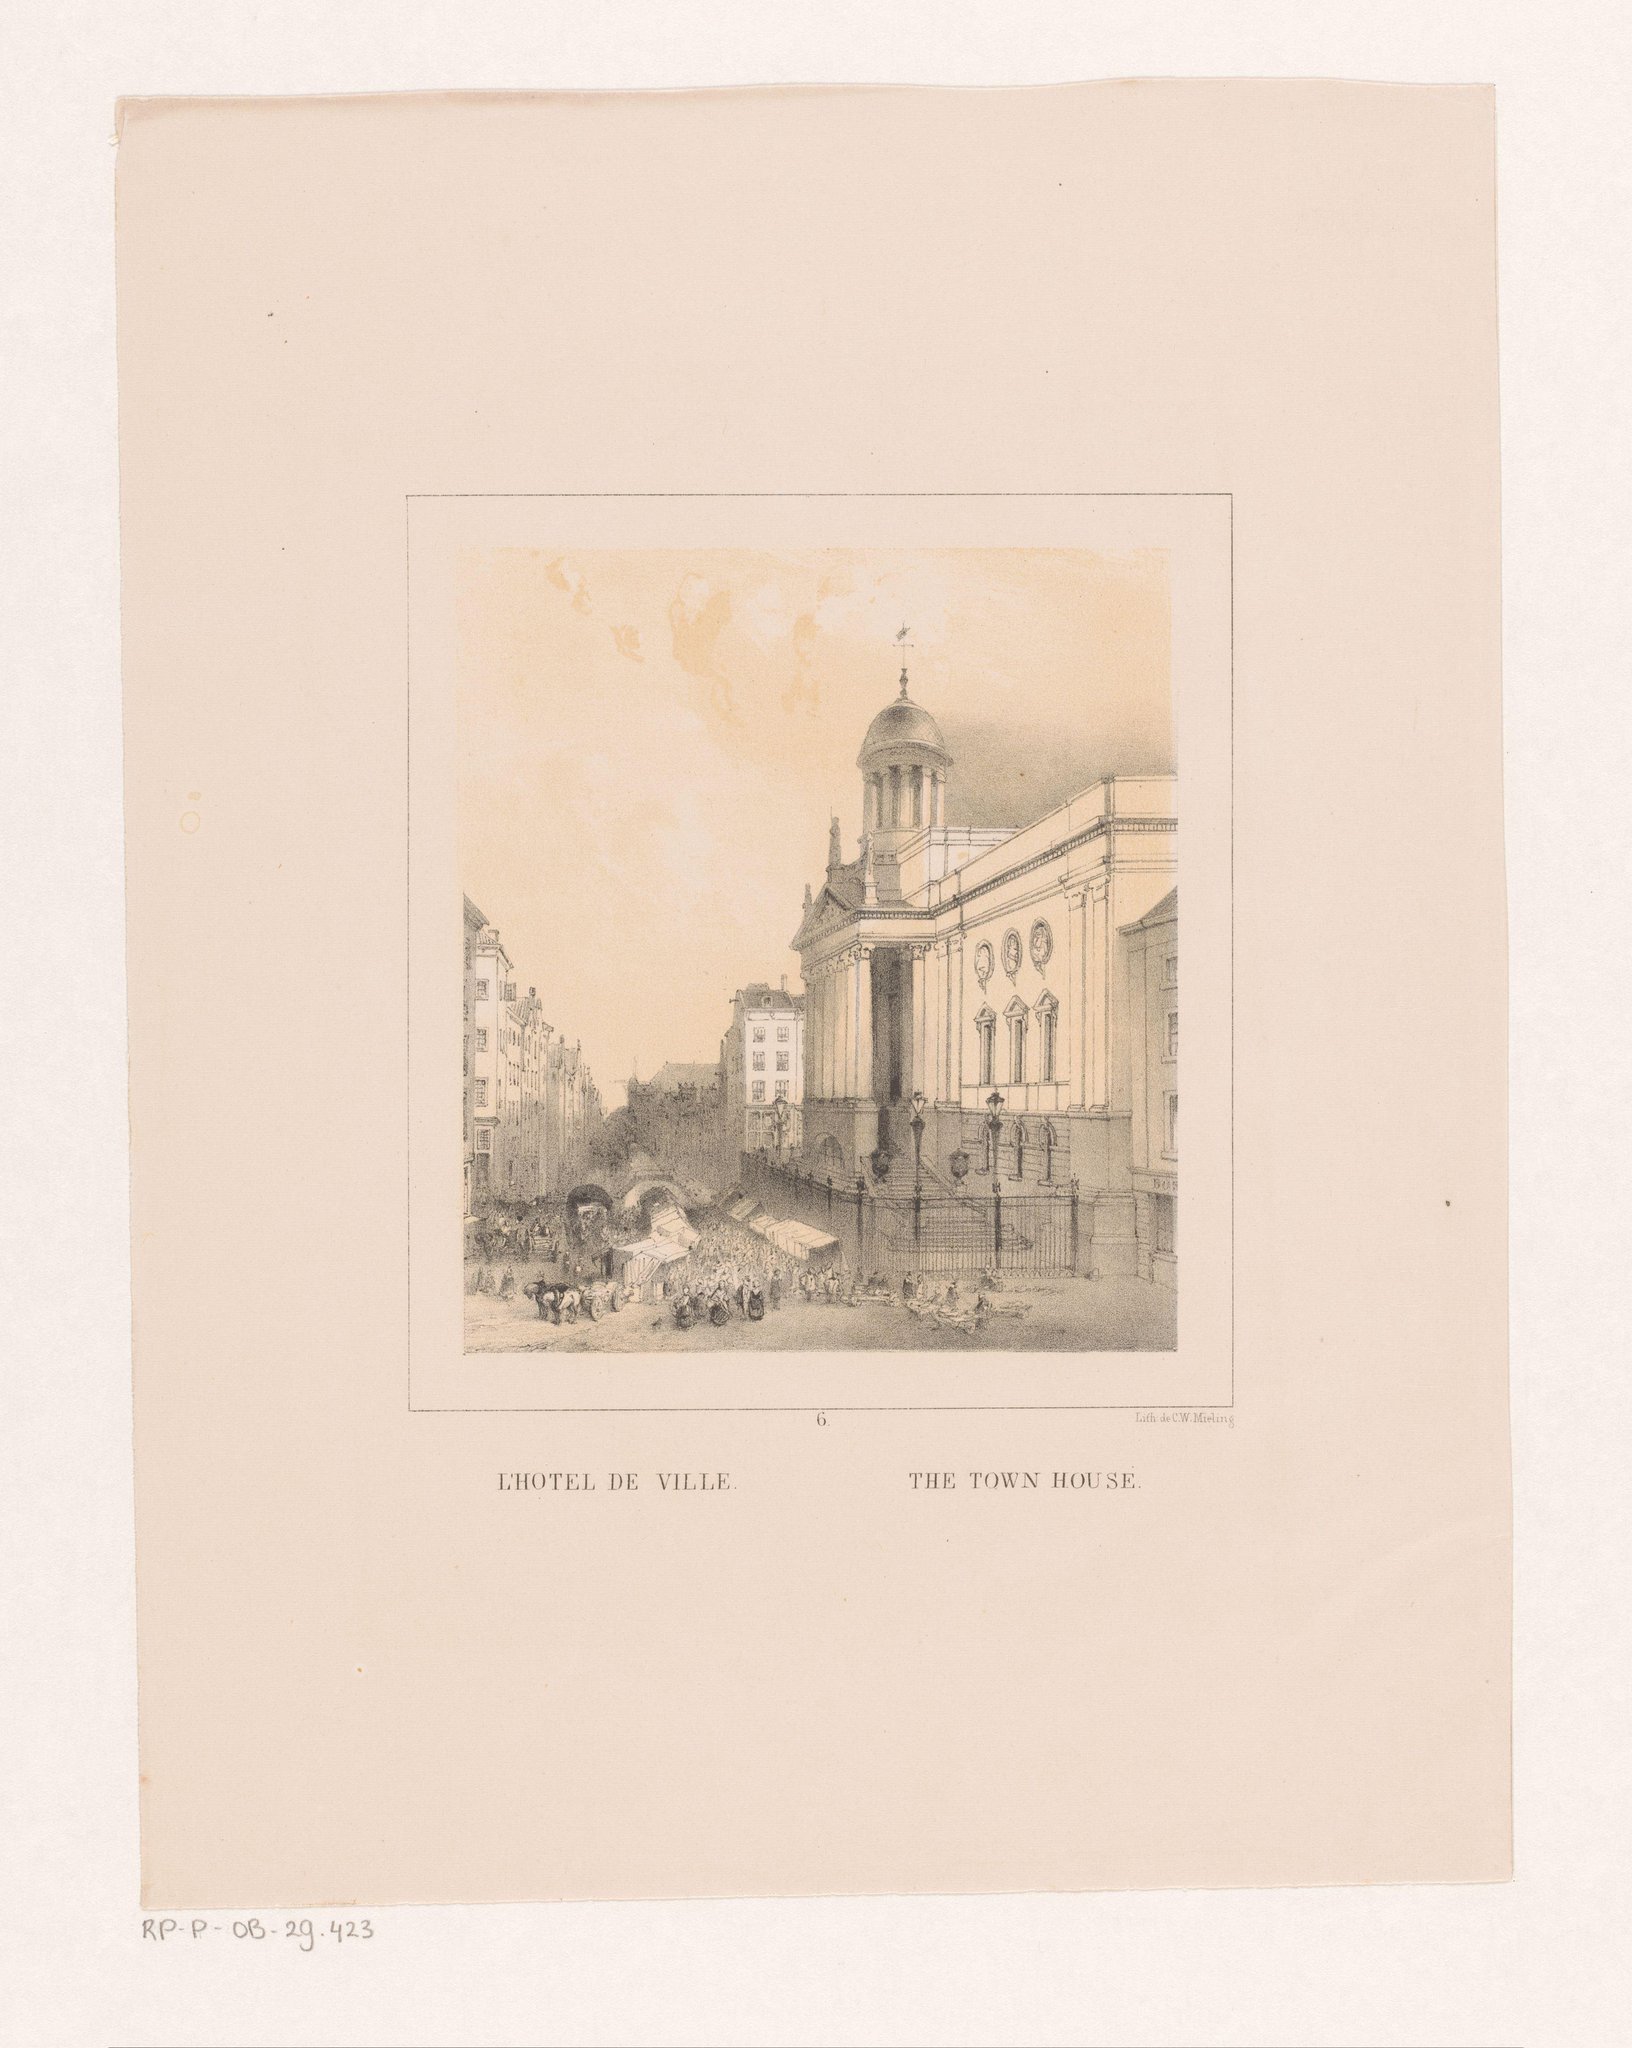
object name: print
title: L'Hotel de Ville / The town house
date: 1839-1844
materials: paper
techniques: tone lithography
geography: rotterdam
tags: townhall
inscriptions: collector's mark: Lugt 2228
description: Gezicht op het stadhuis en de daarvoor gelegen Kaasmarkt te Rotterdam.